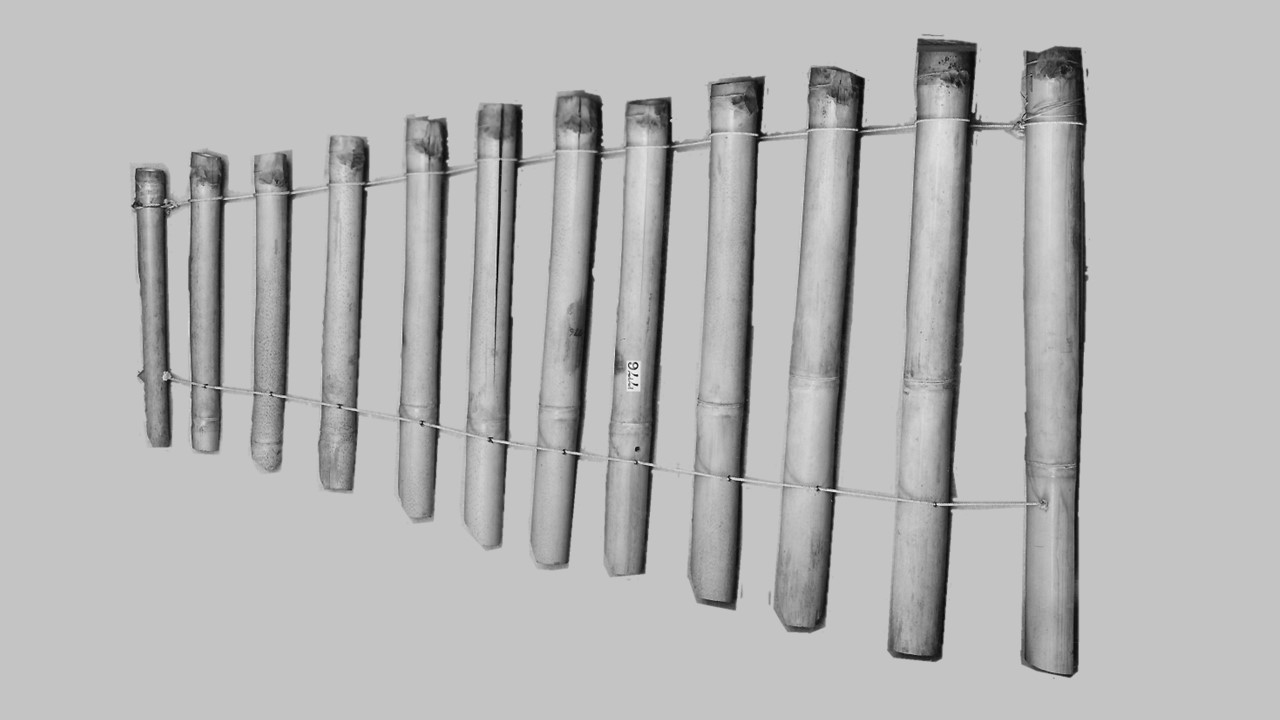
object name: calung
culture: javanese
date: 1867-1900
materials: bamboo, cord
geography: indonesia